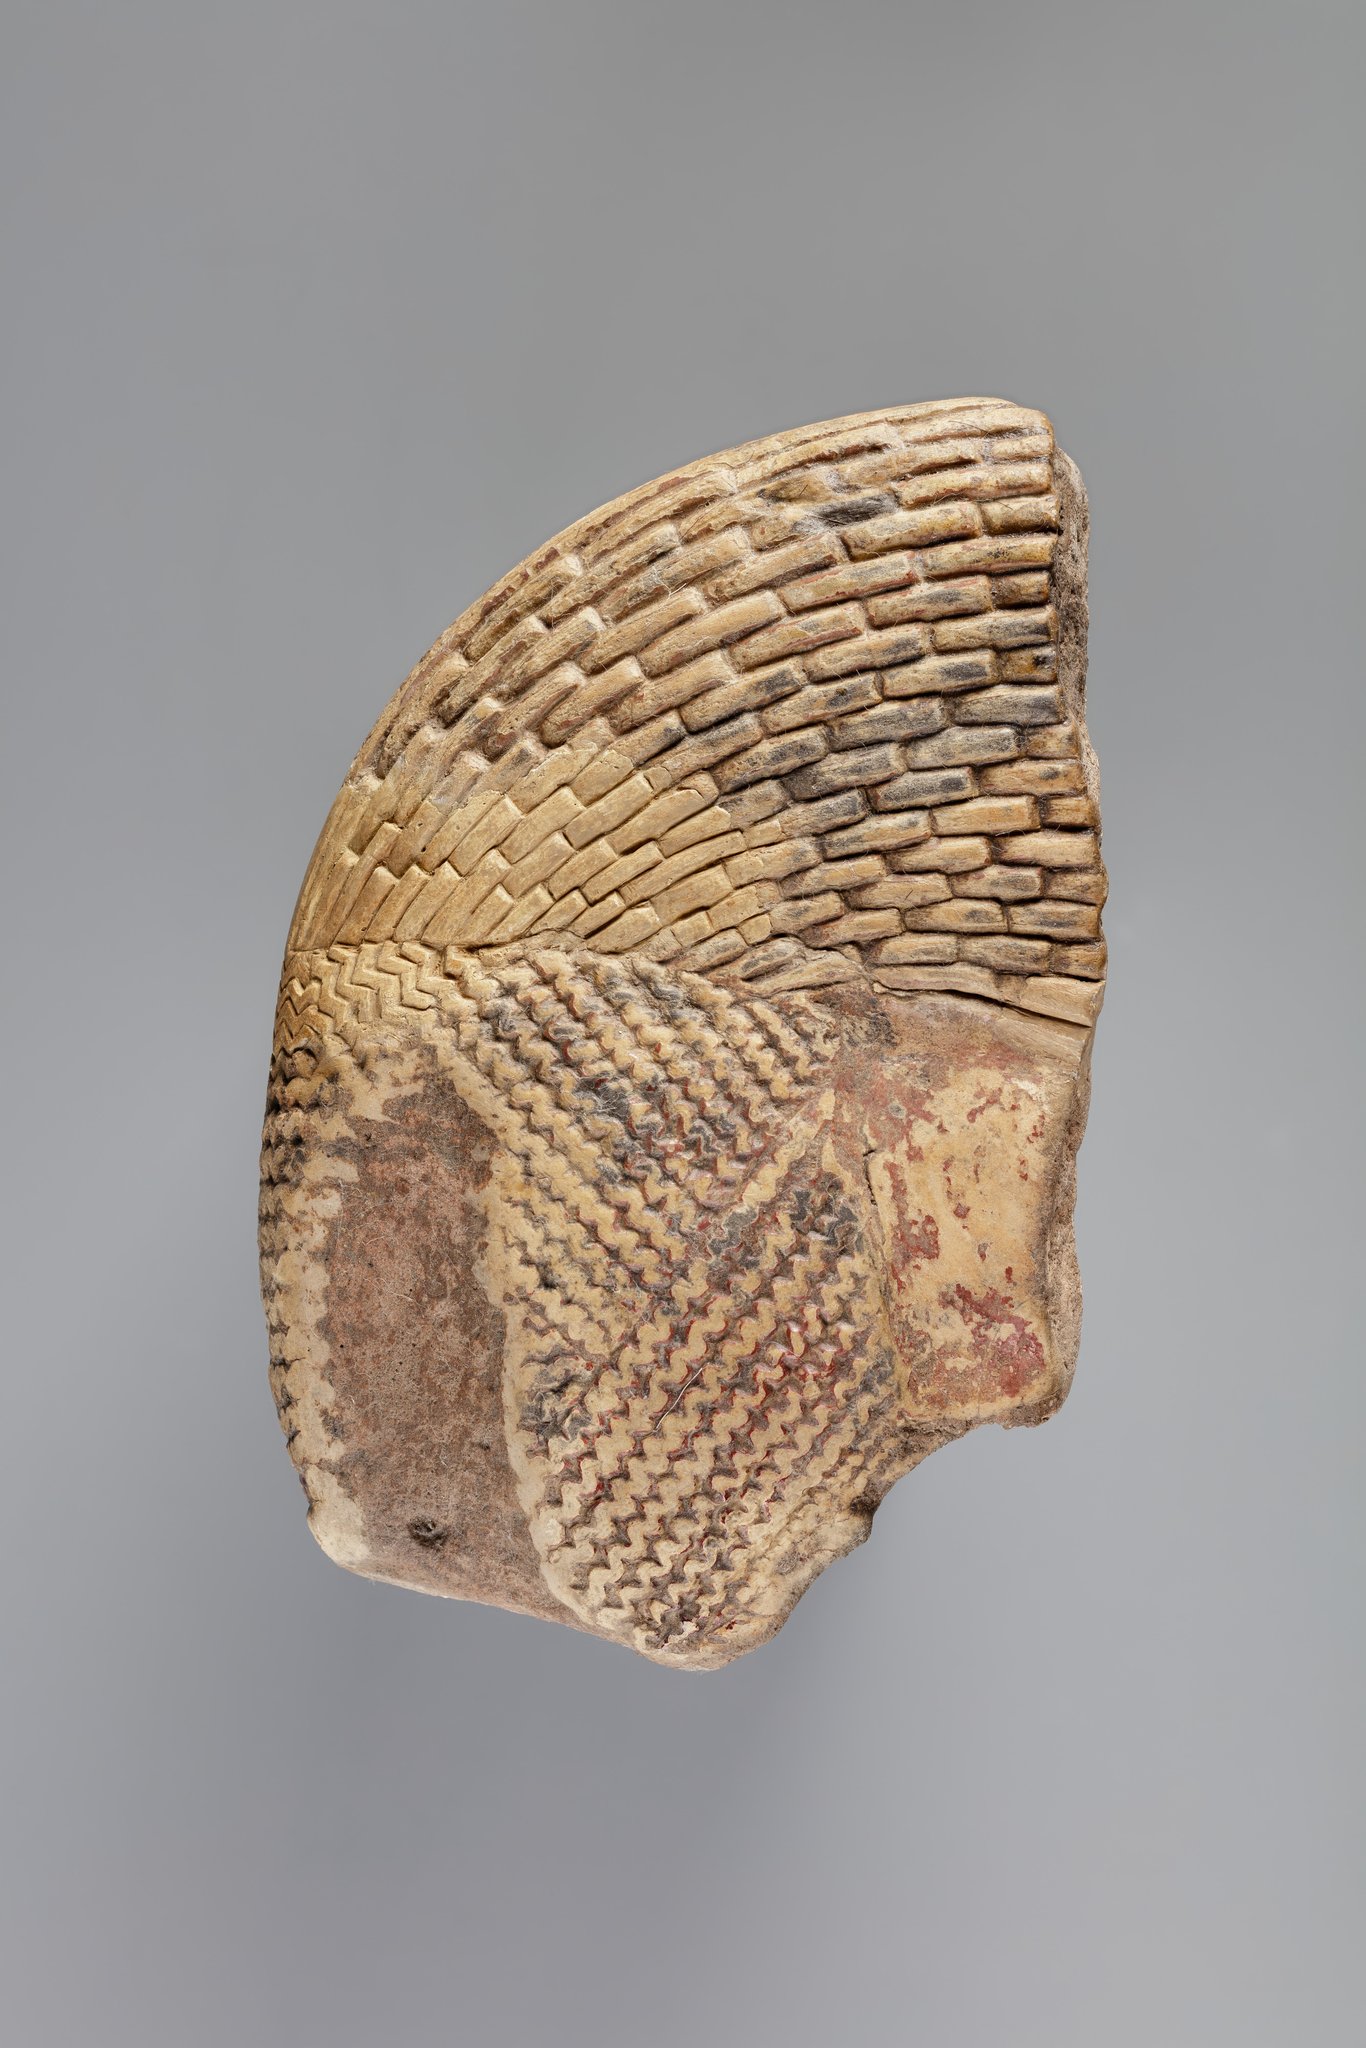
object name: tile, palace of ramesses ii, headdress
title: Tile fragment, part of a wig from a figure of the king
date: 1279-1213 BCE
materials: faience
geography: egypt